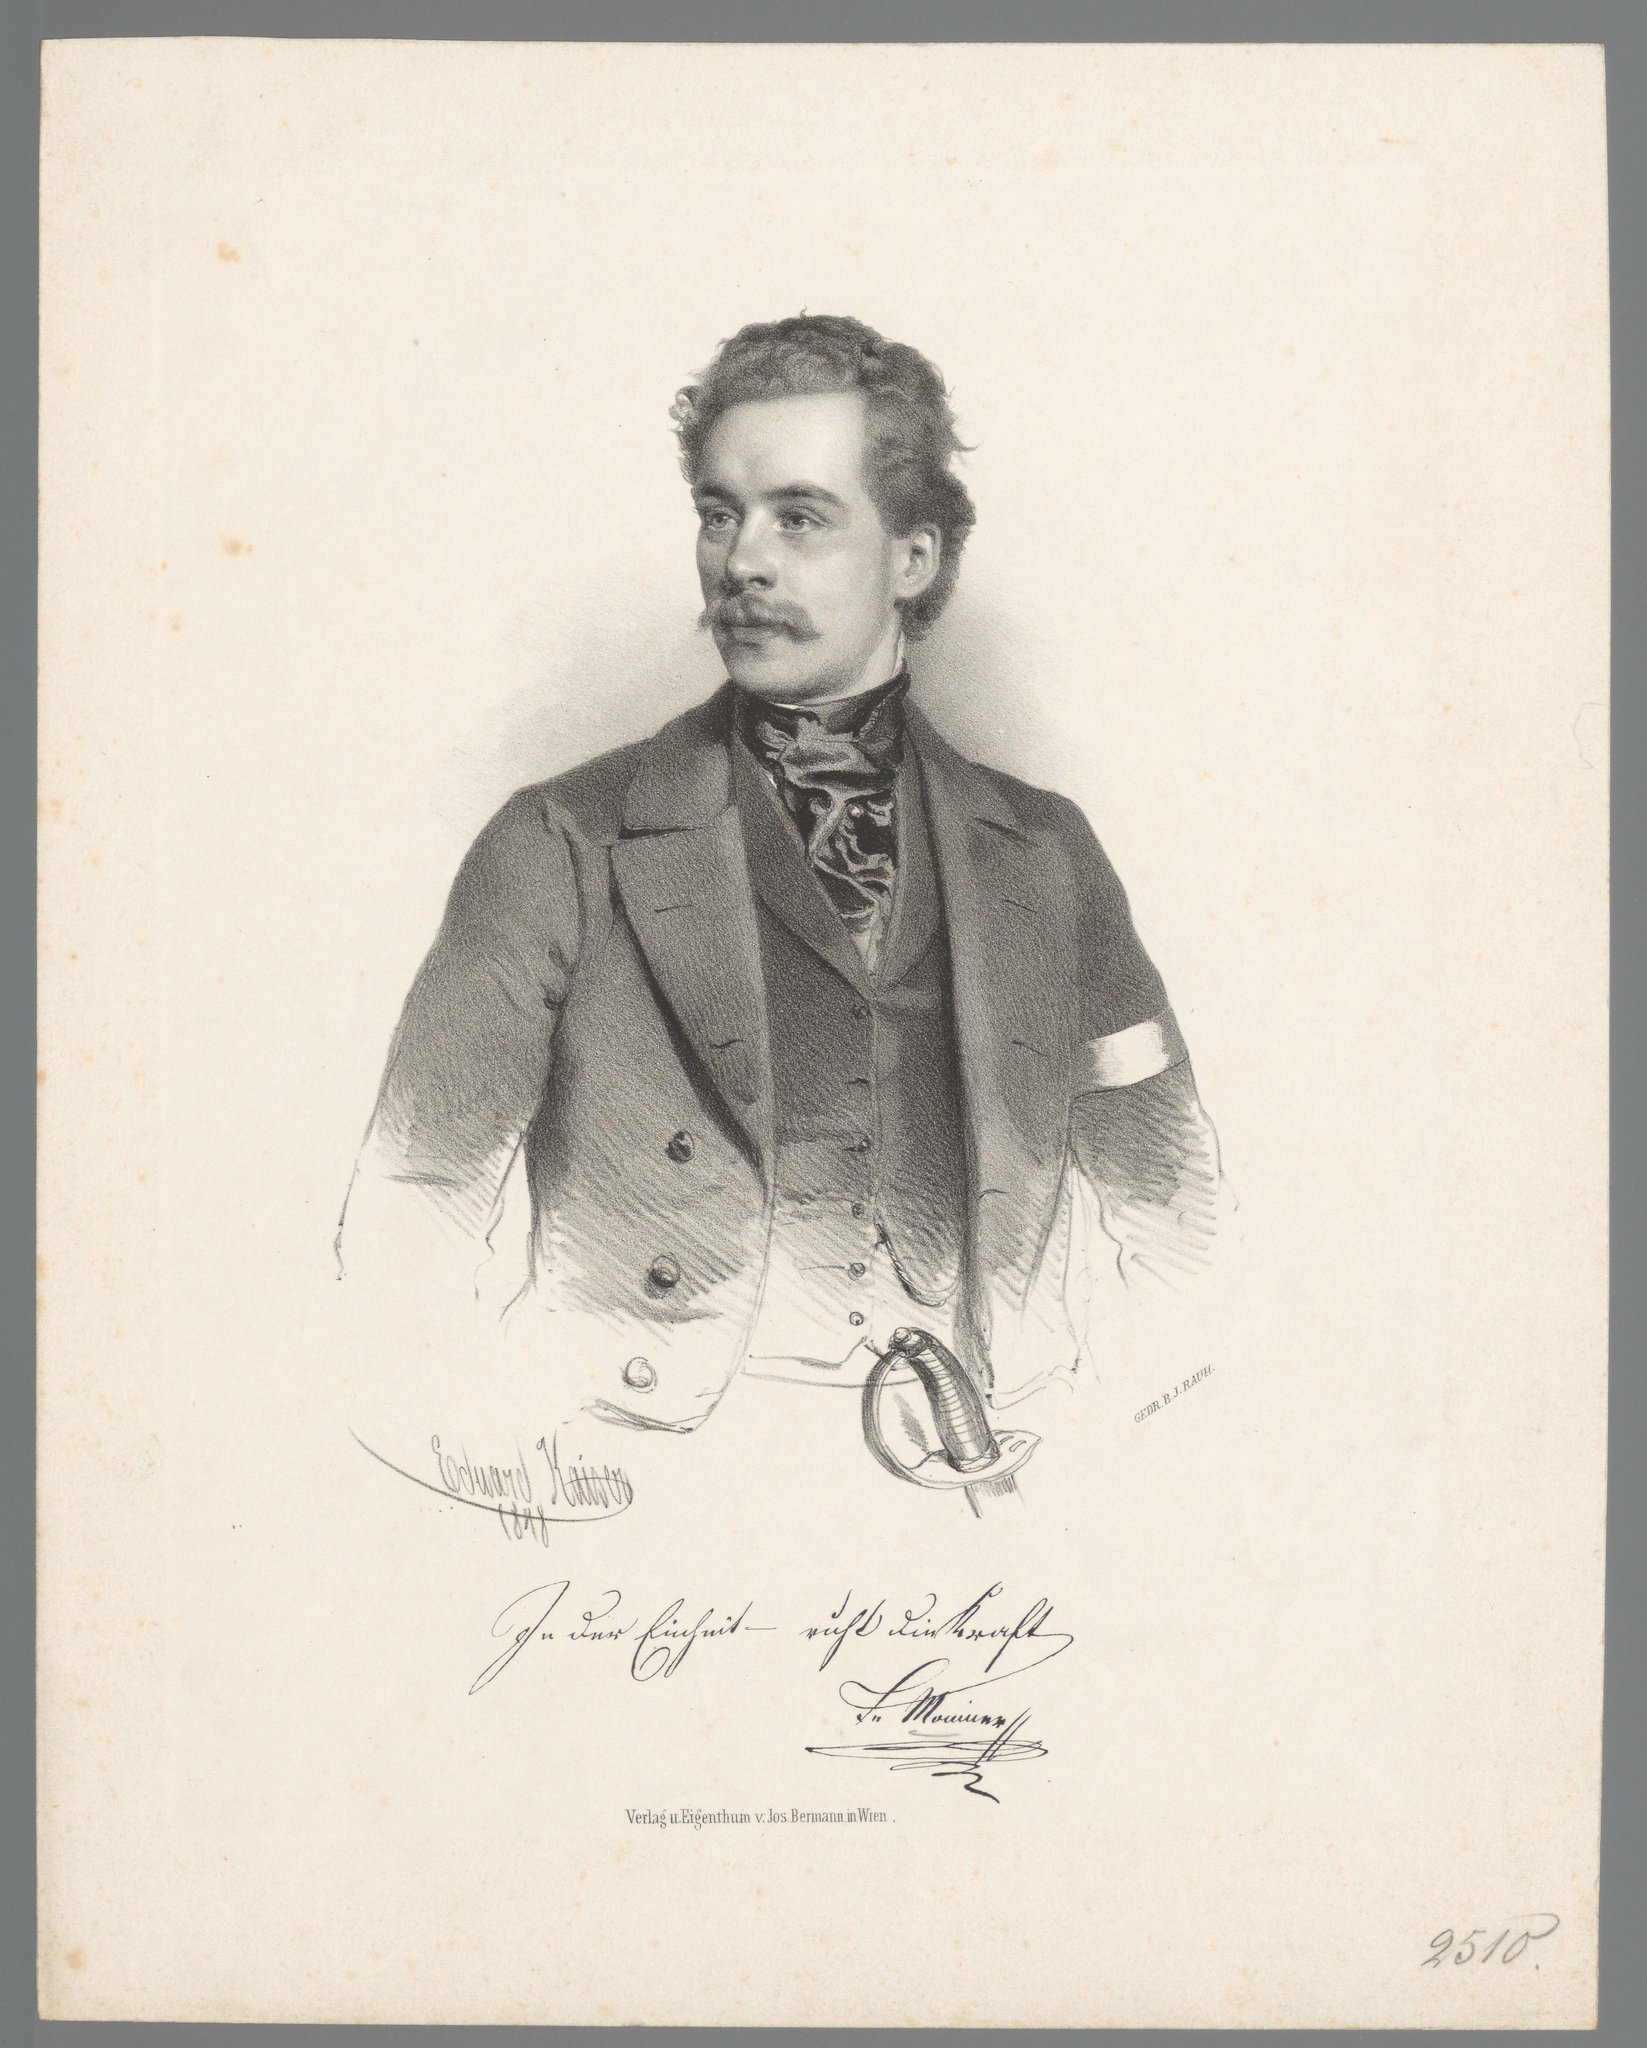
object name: print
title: Portret van een onbekende man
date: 1848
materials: paper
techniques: lithograph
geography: vienna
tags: moustache, adult man, historical persons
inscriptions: collector's mark: Lugt 2228